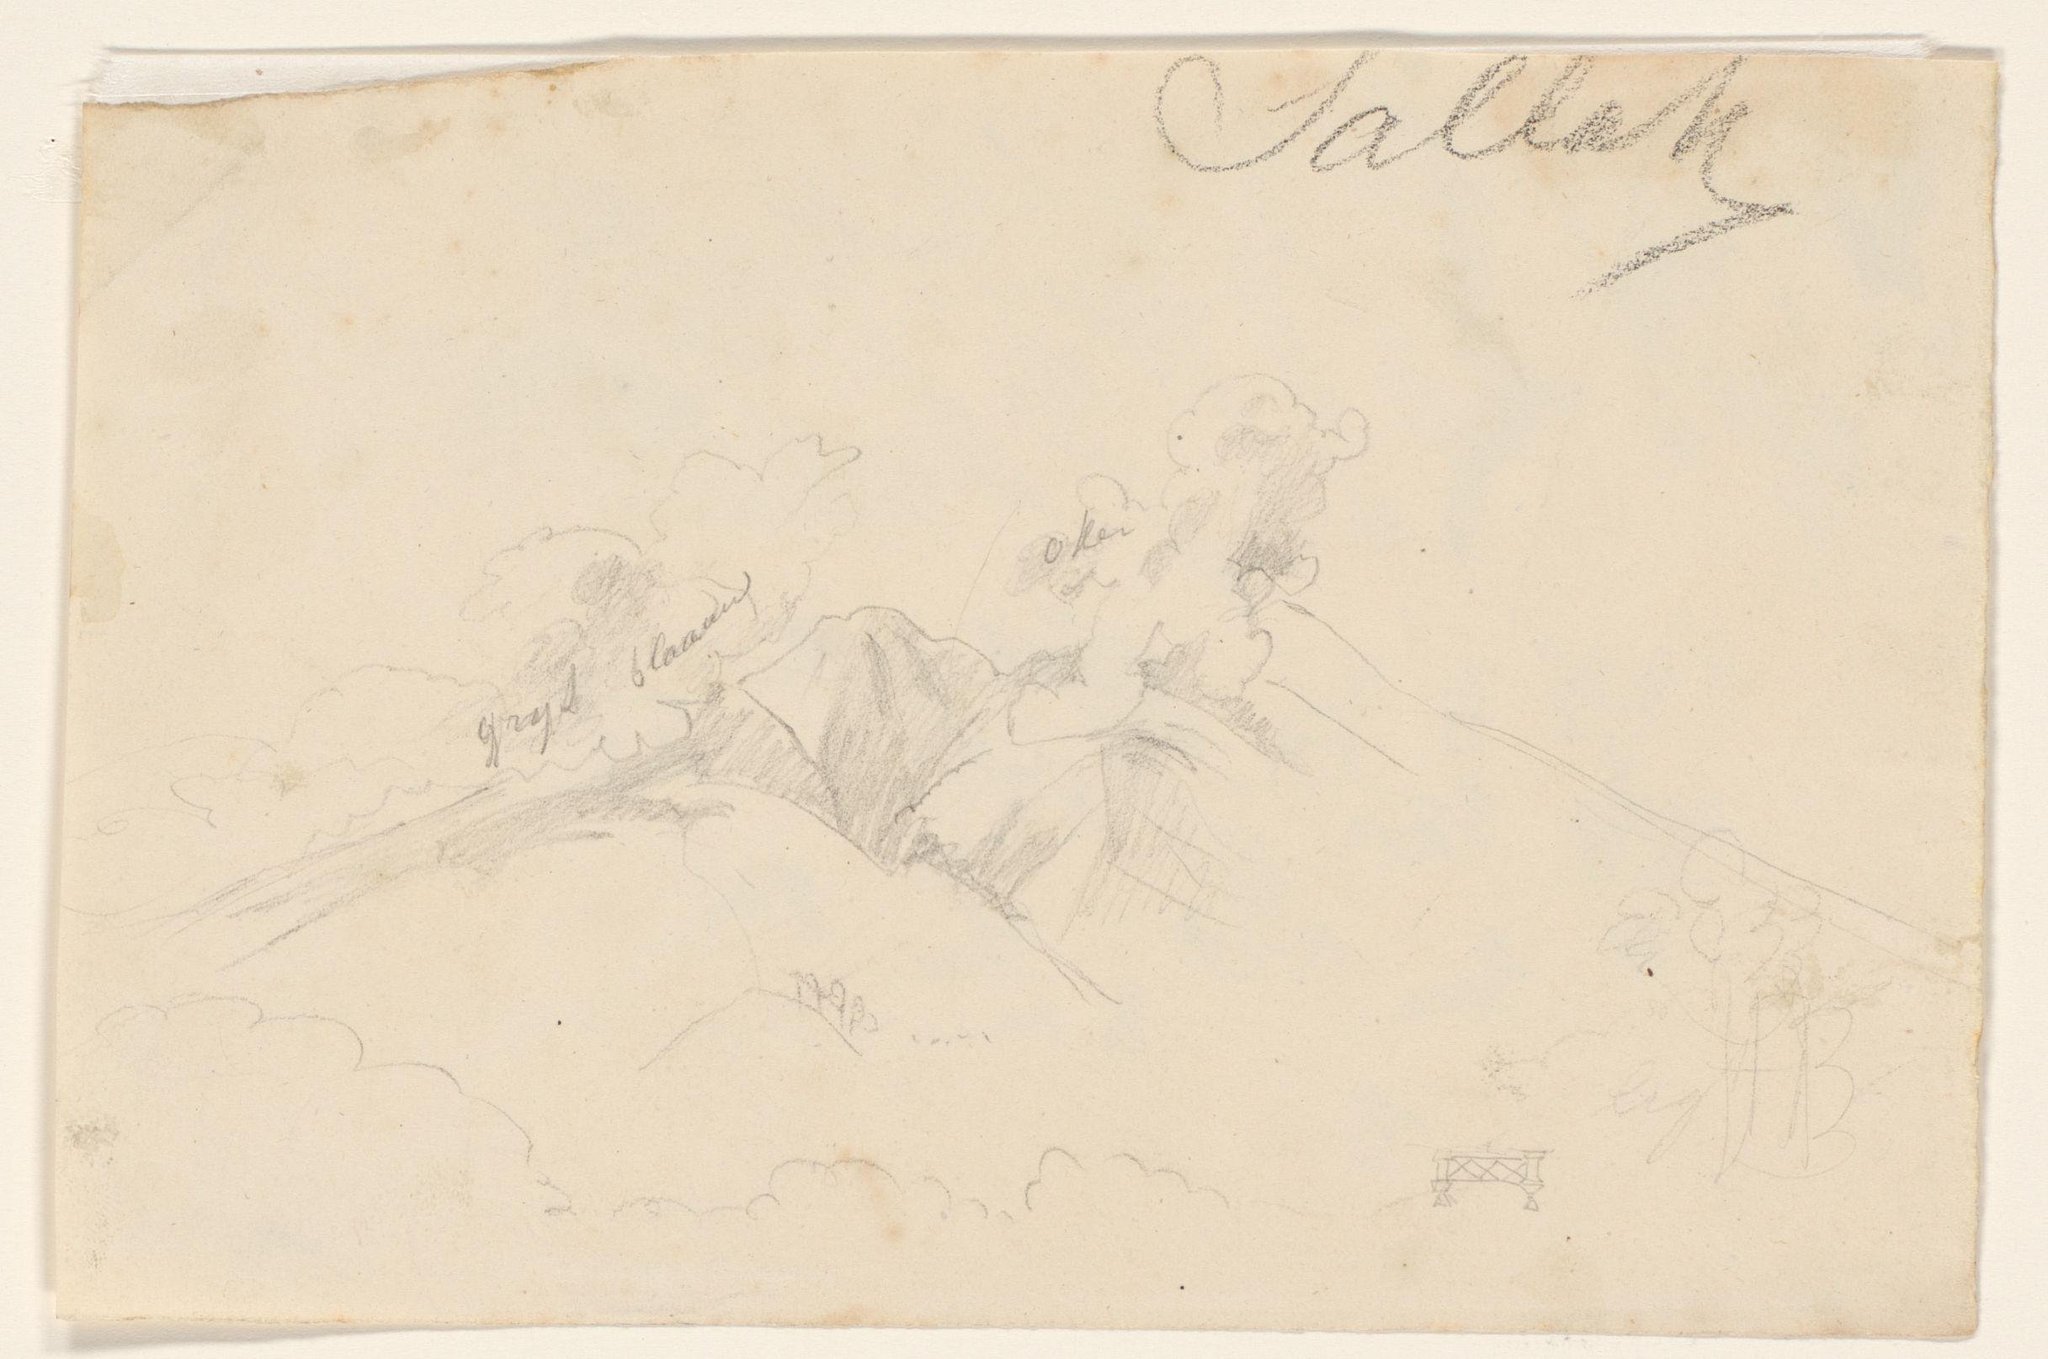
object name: drawing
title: Gezicht op de Salak, West-Java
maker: adrianus johannes bik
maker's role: draughtsman, print maker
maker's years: 1790-1872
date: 1816-1846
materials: paper, pencil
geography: west java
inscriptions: inscription: ‘Sallak’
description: artikel over deze collectie in Bulletin van het Rijksmuseum 49 [2001], nr. 4, pp 342 e.v.